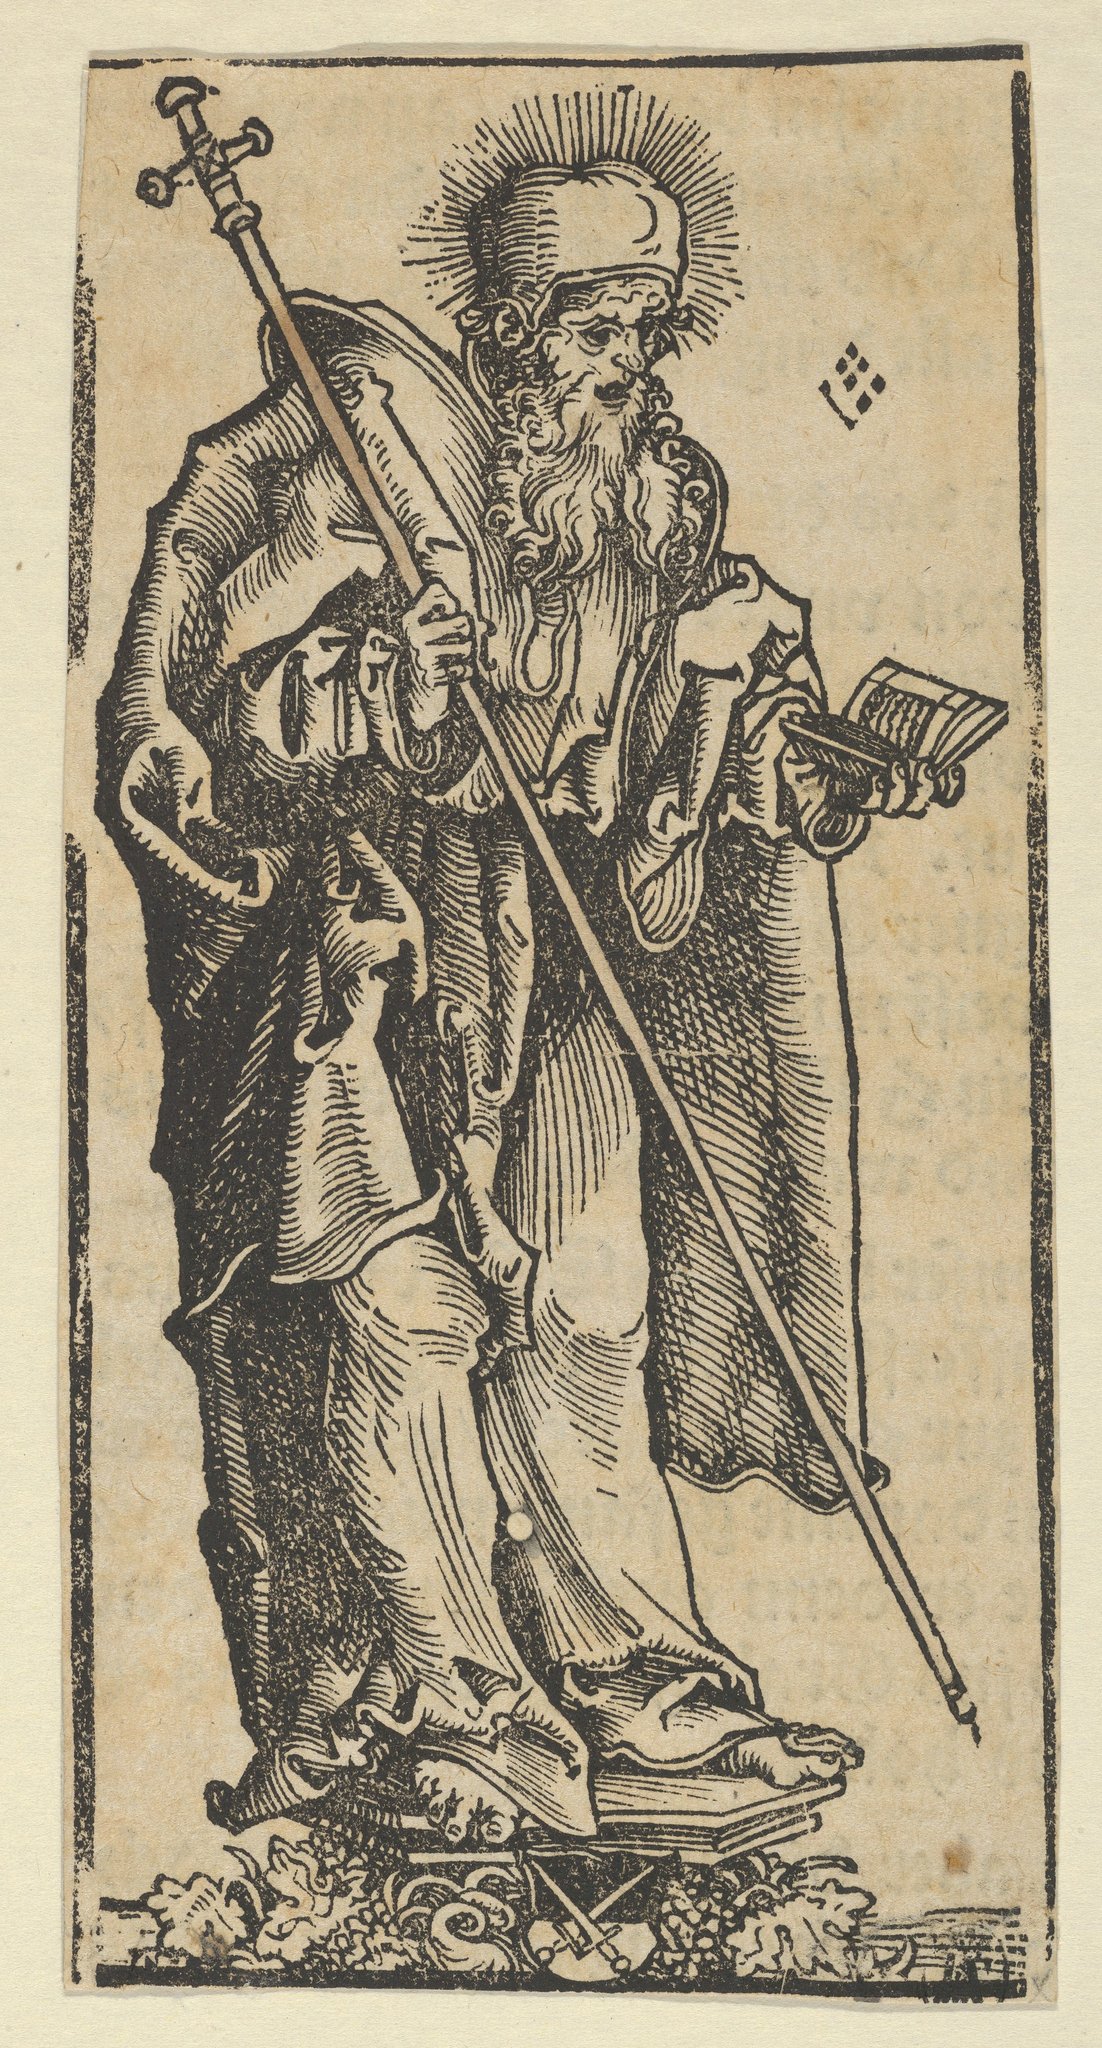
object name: print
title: Silver Statuette of St. Philip, from the "Wittenberg Reliquaries"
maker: lucas cranach the elder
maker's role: artist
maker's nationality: german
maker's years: 1472-1553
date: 1472-1553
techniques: woodcut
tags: books,men,saints